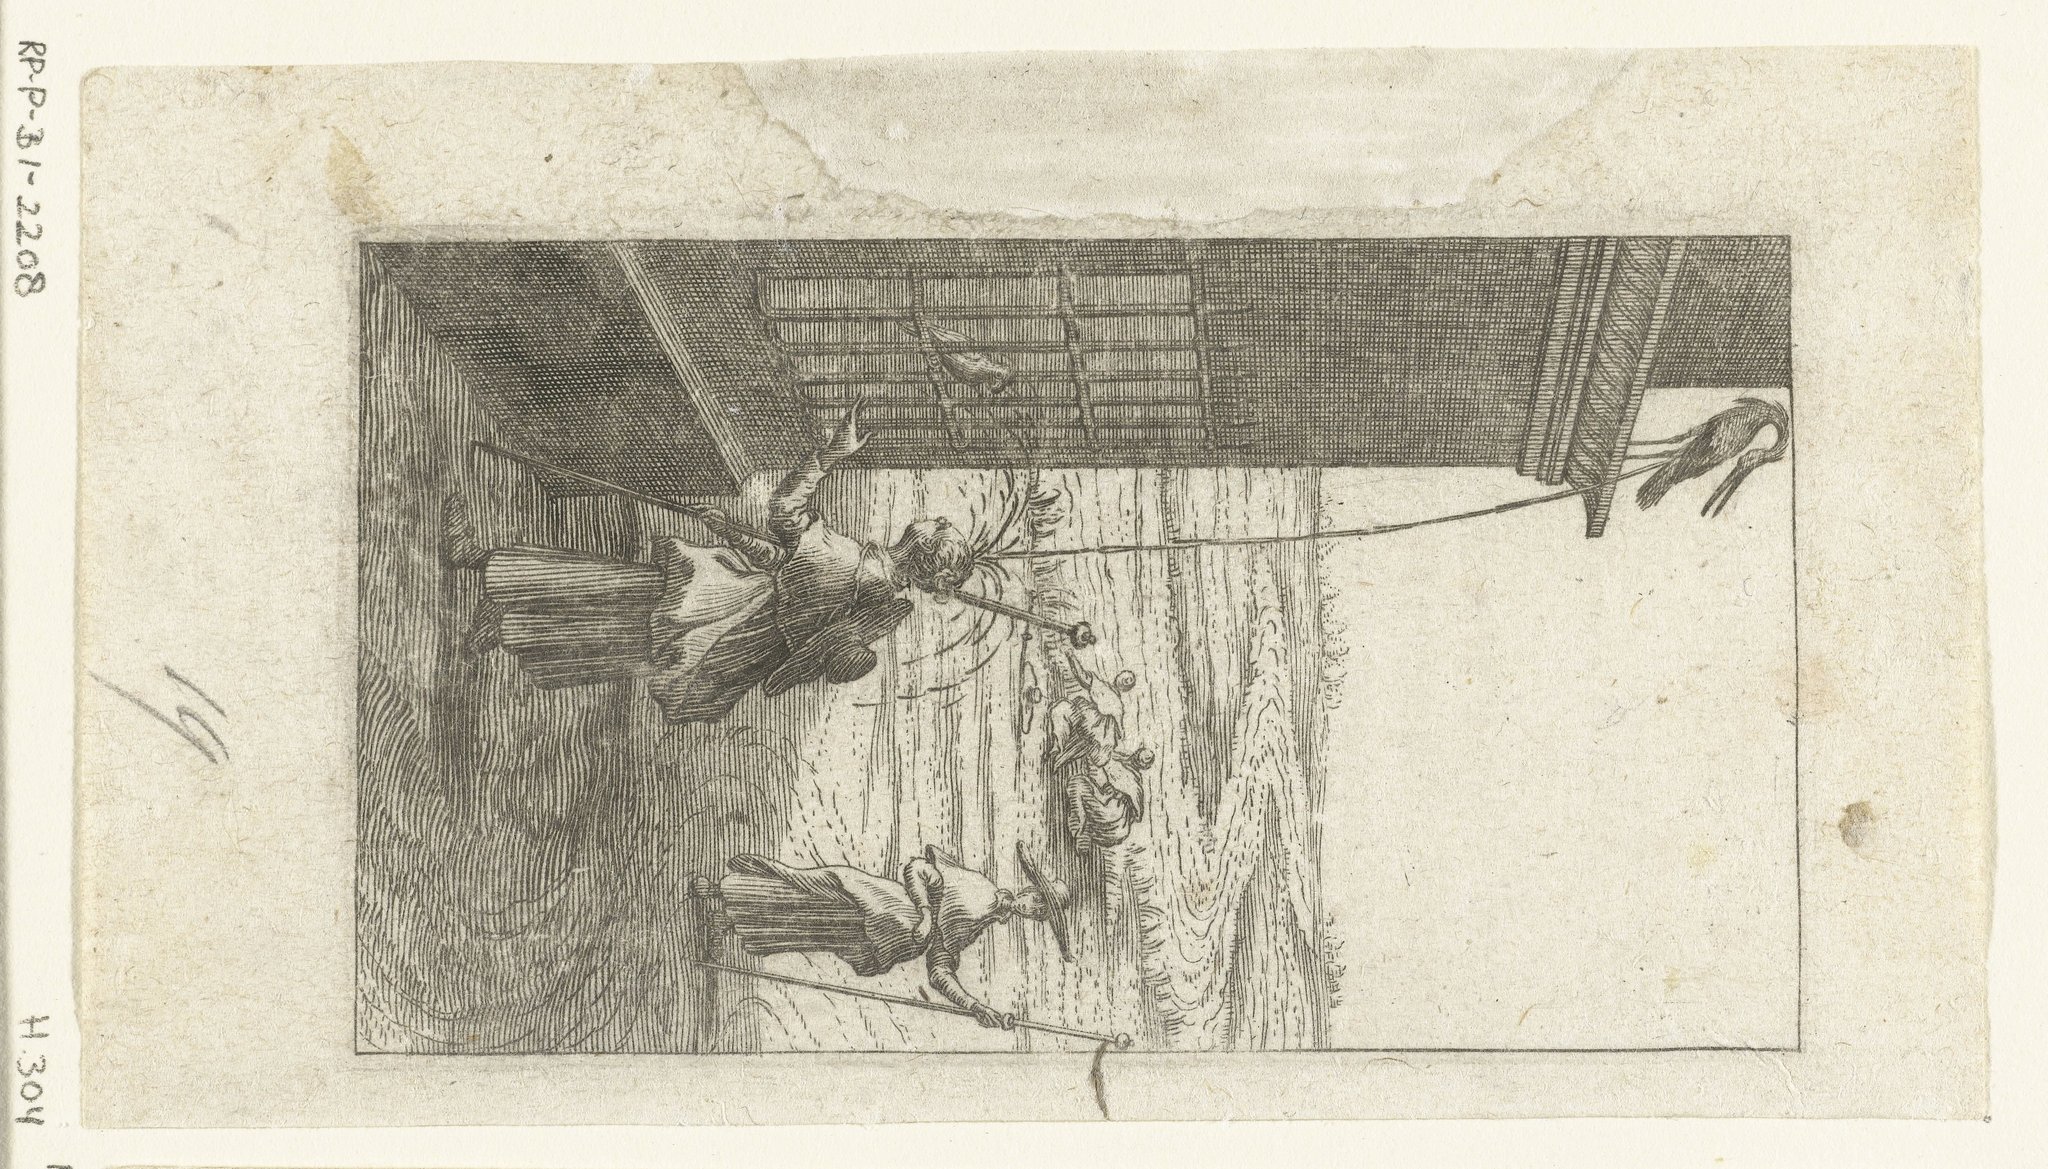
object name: book illustration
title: Duyfkens en Willemynkens pelgrimagie tot haren beminden binnen Iervsalem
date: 1590-1627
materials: paper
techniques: engraving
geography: antwerp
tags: birds, pilgrimage, pilgrim(s) under way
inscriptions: collector's mark: Lugt 2228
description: Prent uit: Boëtius Adamsz. Bolswert, Duyfkens en Willemynkens pelgrimagie tot haren beminden binnen Iervsalem. Haerlieder teghenspoet, belet en eynde, Antwerpen, Hendrick Aertssens, eerste druk 1627. Op het verso van deze prent staat geen tekst, waarschijnlijk is het blad afkomstig uit een latere druk.